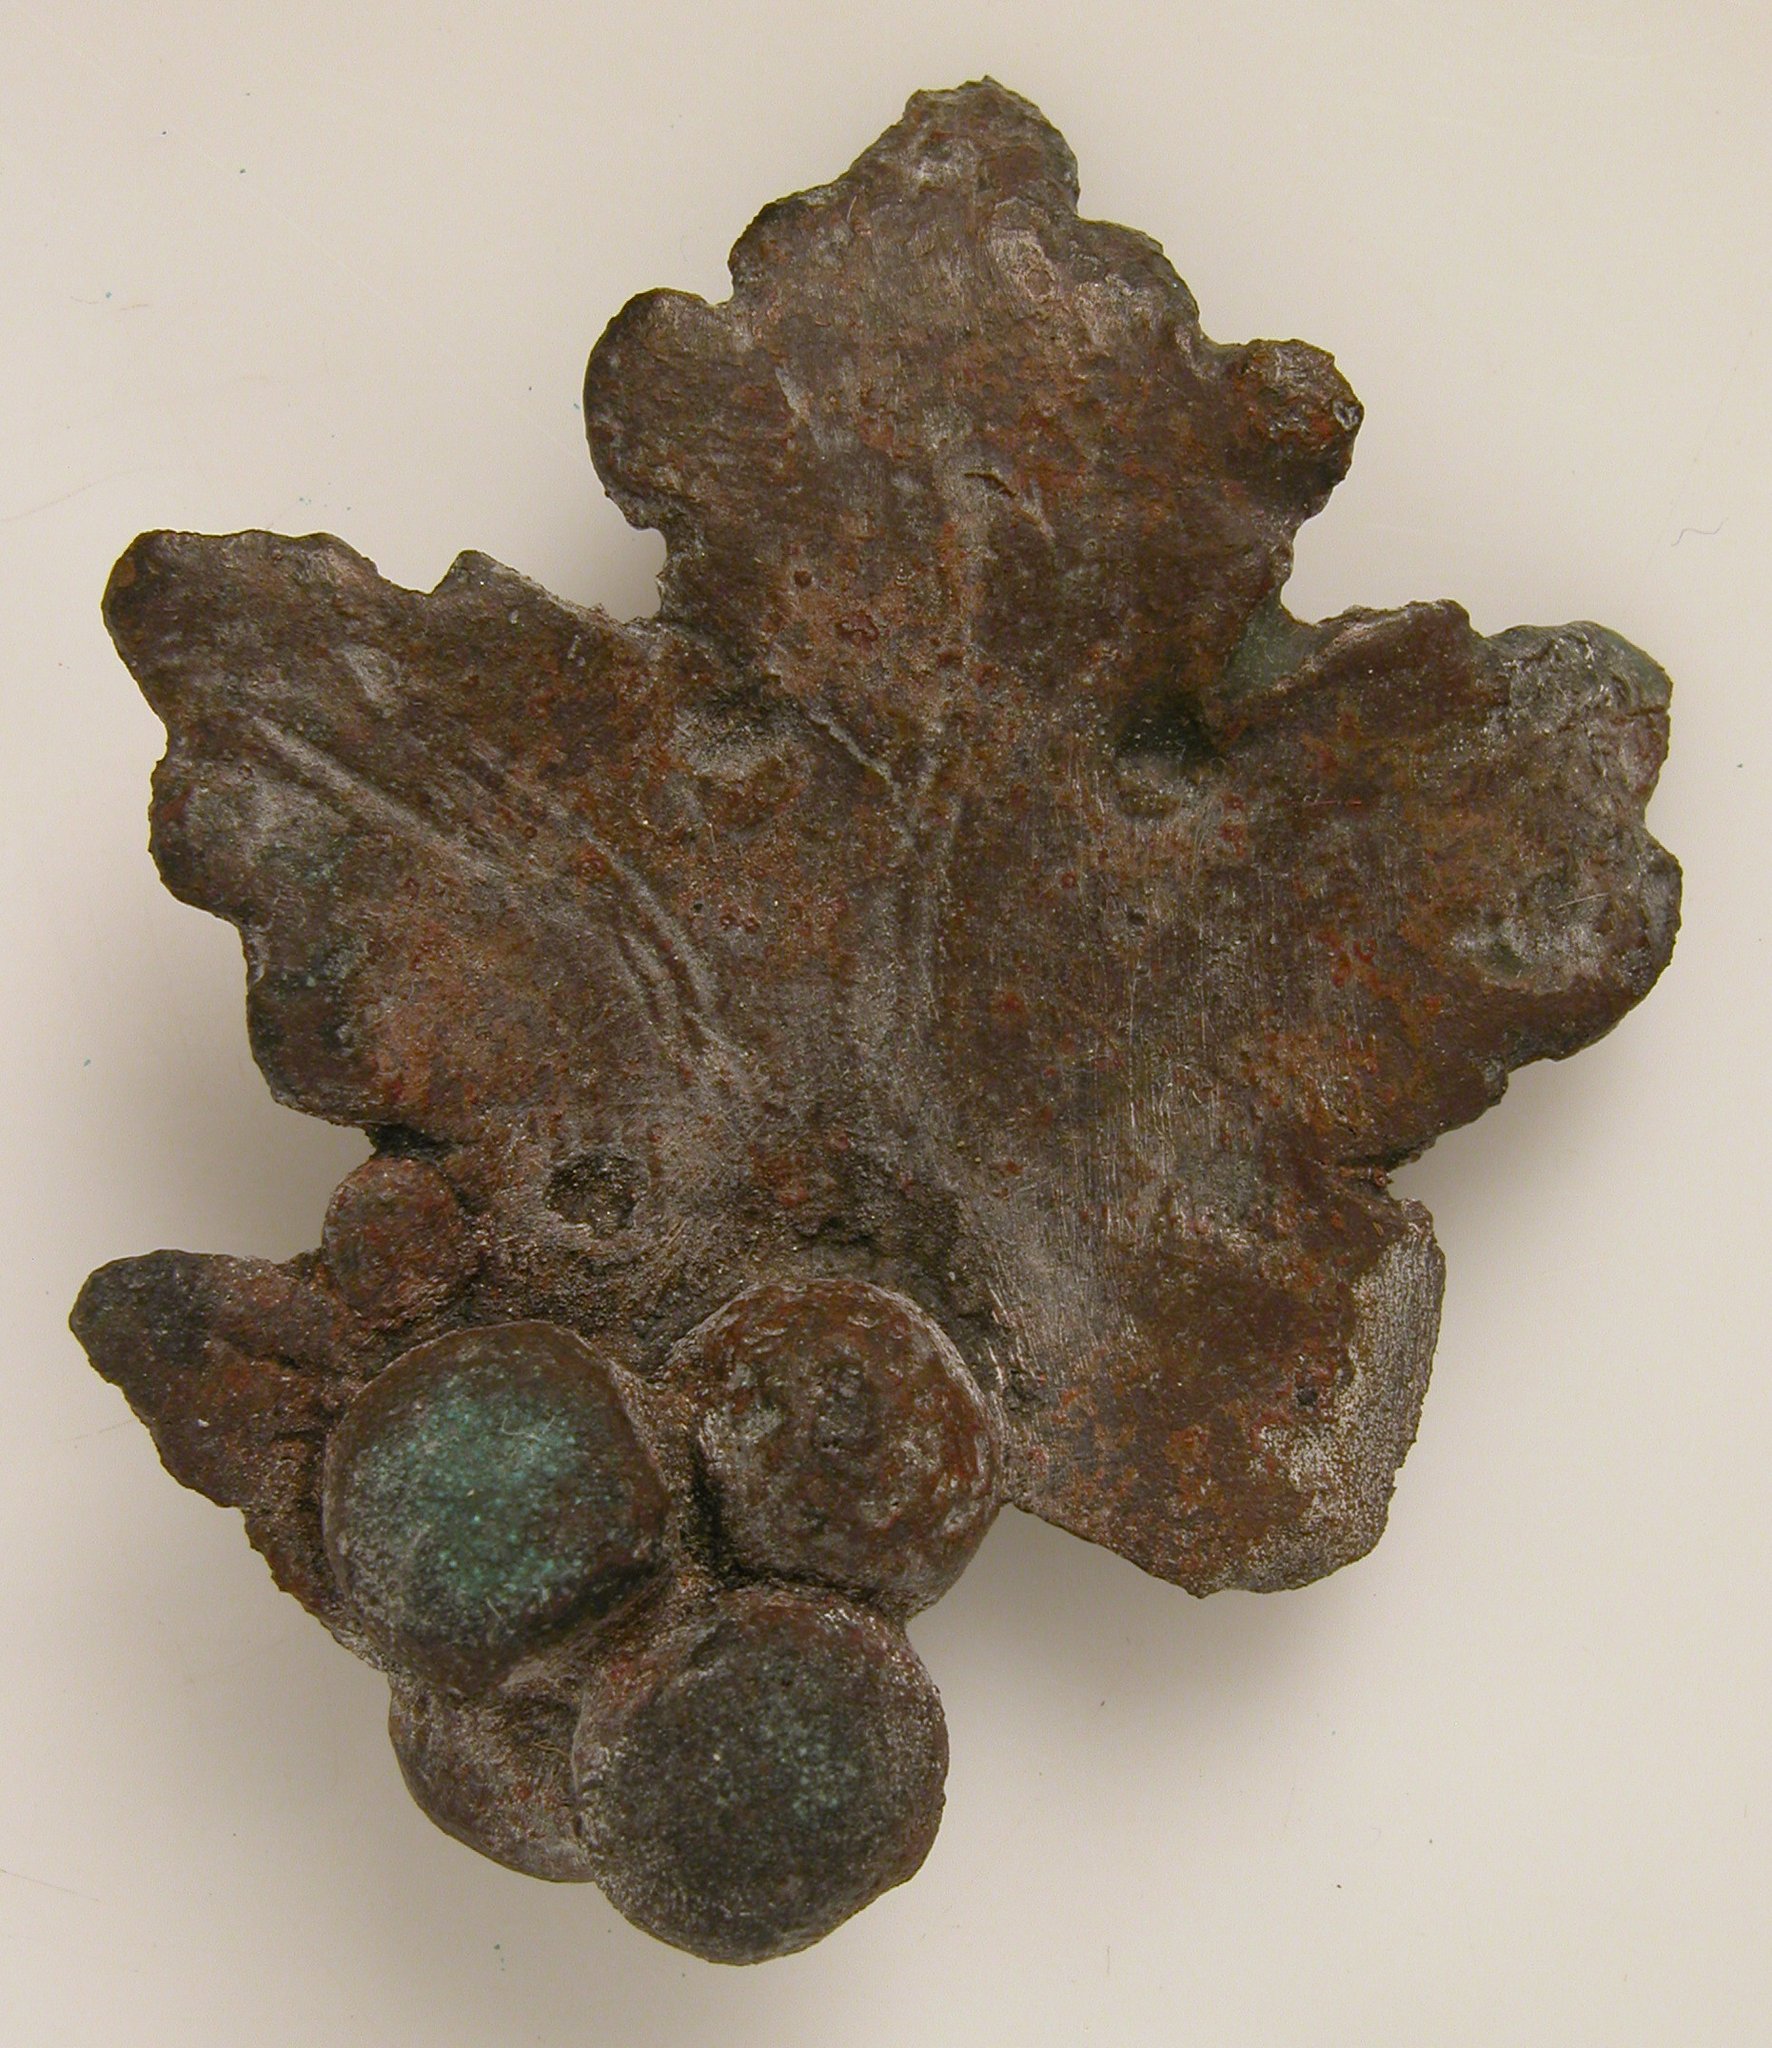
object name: ornament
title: Grapes and Grape Leaf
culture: coptic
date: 201-300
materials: copper alloy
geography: egypt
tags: grapes,leaves